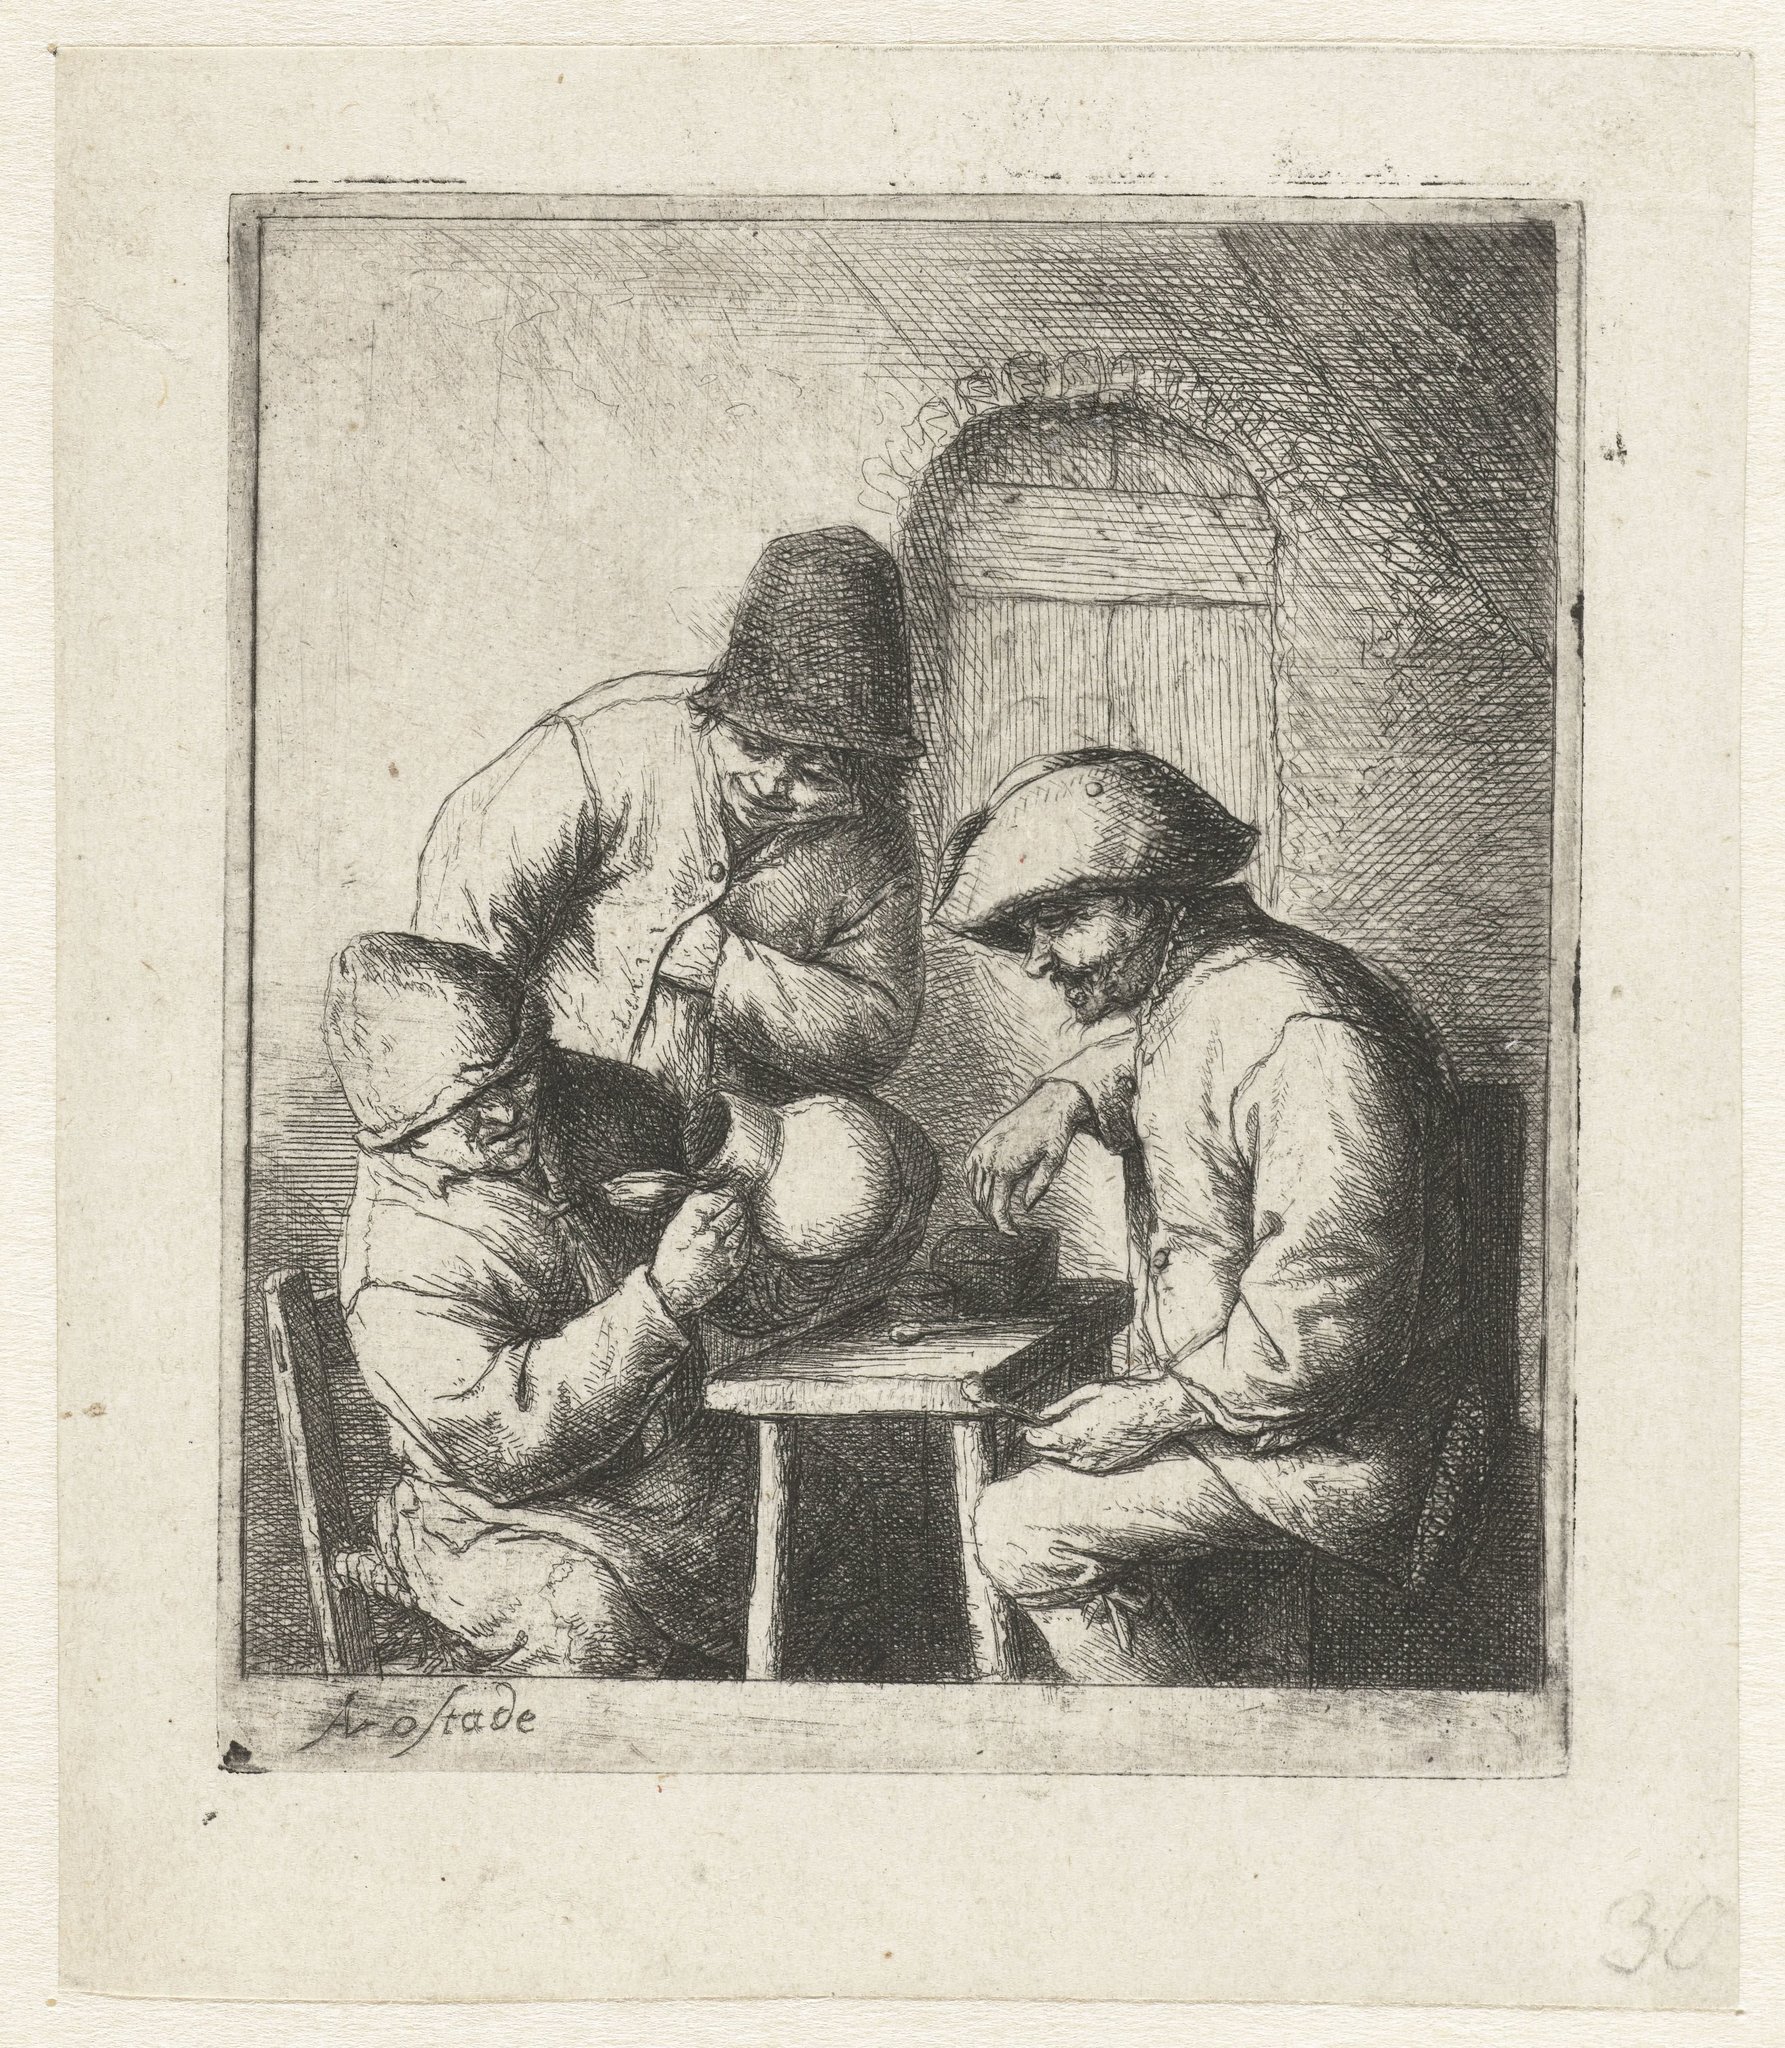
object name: print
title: Man kijkt in lege kruik, twee mannen kijken toe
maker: adriaen van ostade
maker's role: draughtsman, painter, print maker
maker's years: 1610-1685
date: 1651-1655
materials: paper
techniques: drypoint, etching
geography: haarlem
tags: inn, coffee-house, public house, etc., drinking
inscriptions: collector's mark: Lugt 240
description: Enkele gebaren van de mannen in deze voorstelling dragen een negatieve betekenis. De man die in de lege kruik kijkt is een kannekijker ofwel een dronkaard. Het gebaar van de staande man achter hem, met zijn hand verstopt achter zijn hemd, werd in verband gebracht met luiheid.